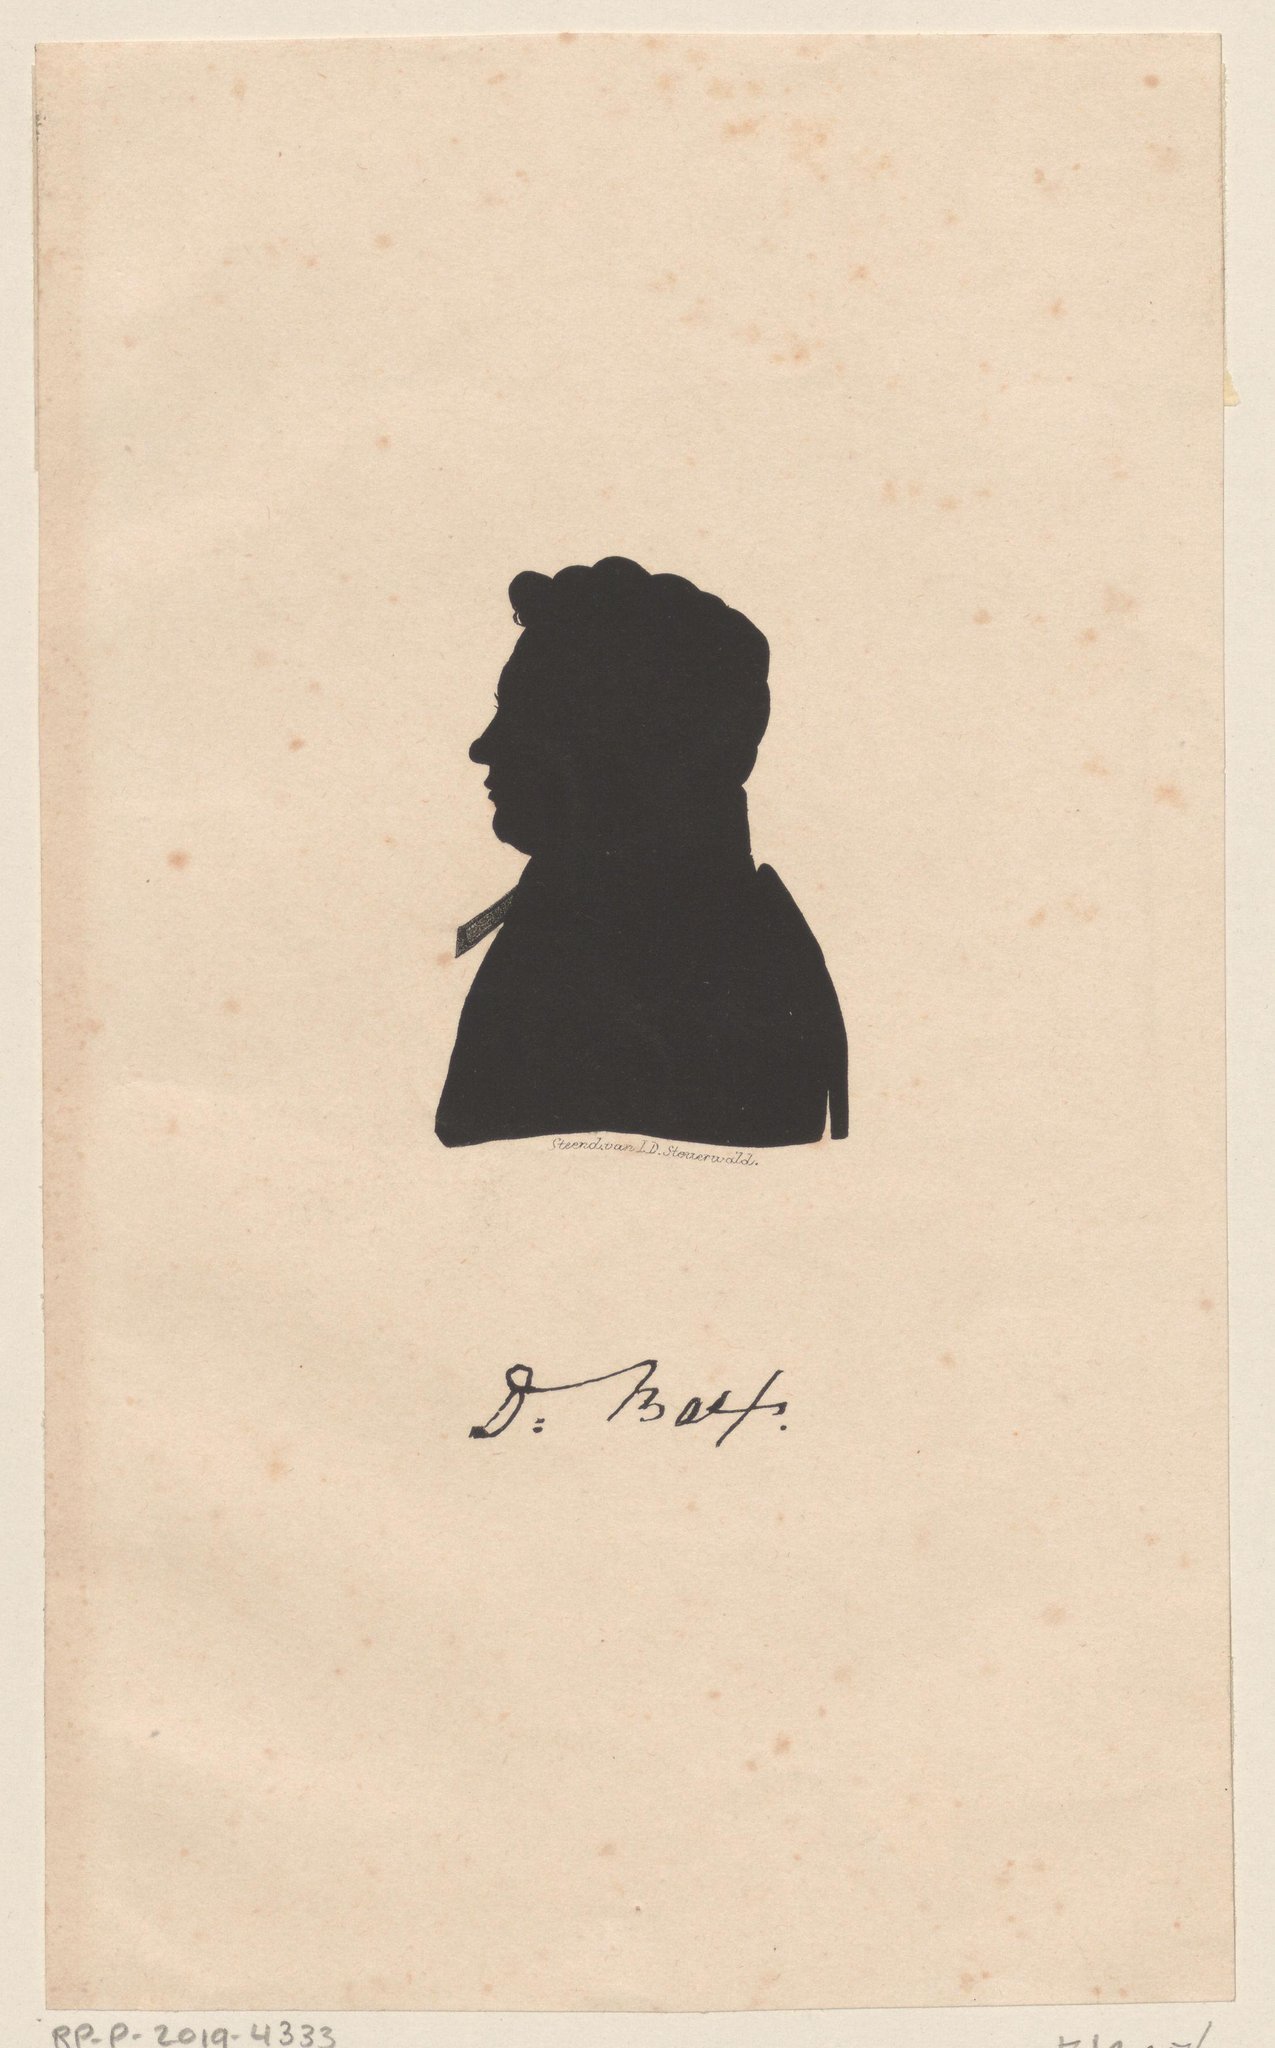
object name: book illustration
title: Silhouetportret van Dirk Bax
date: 1838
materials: paper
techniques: lithograph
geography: zutphen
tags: rotterdam, historical persons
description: Prent uit: Bax, Dirk. Nagelaten gedichten. Zutphen: W.J. Thieme, 1838.